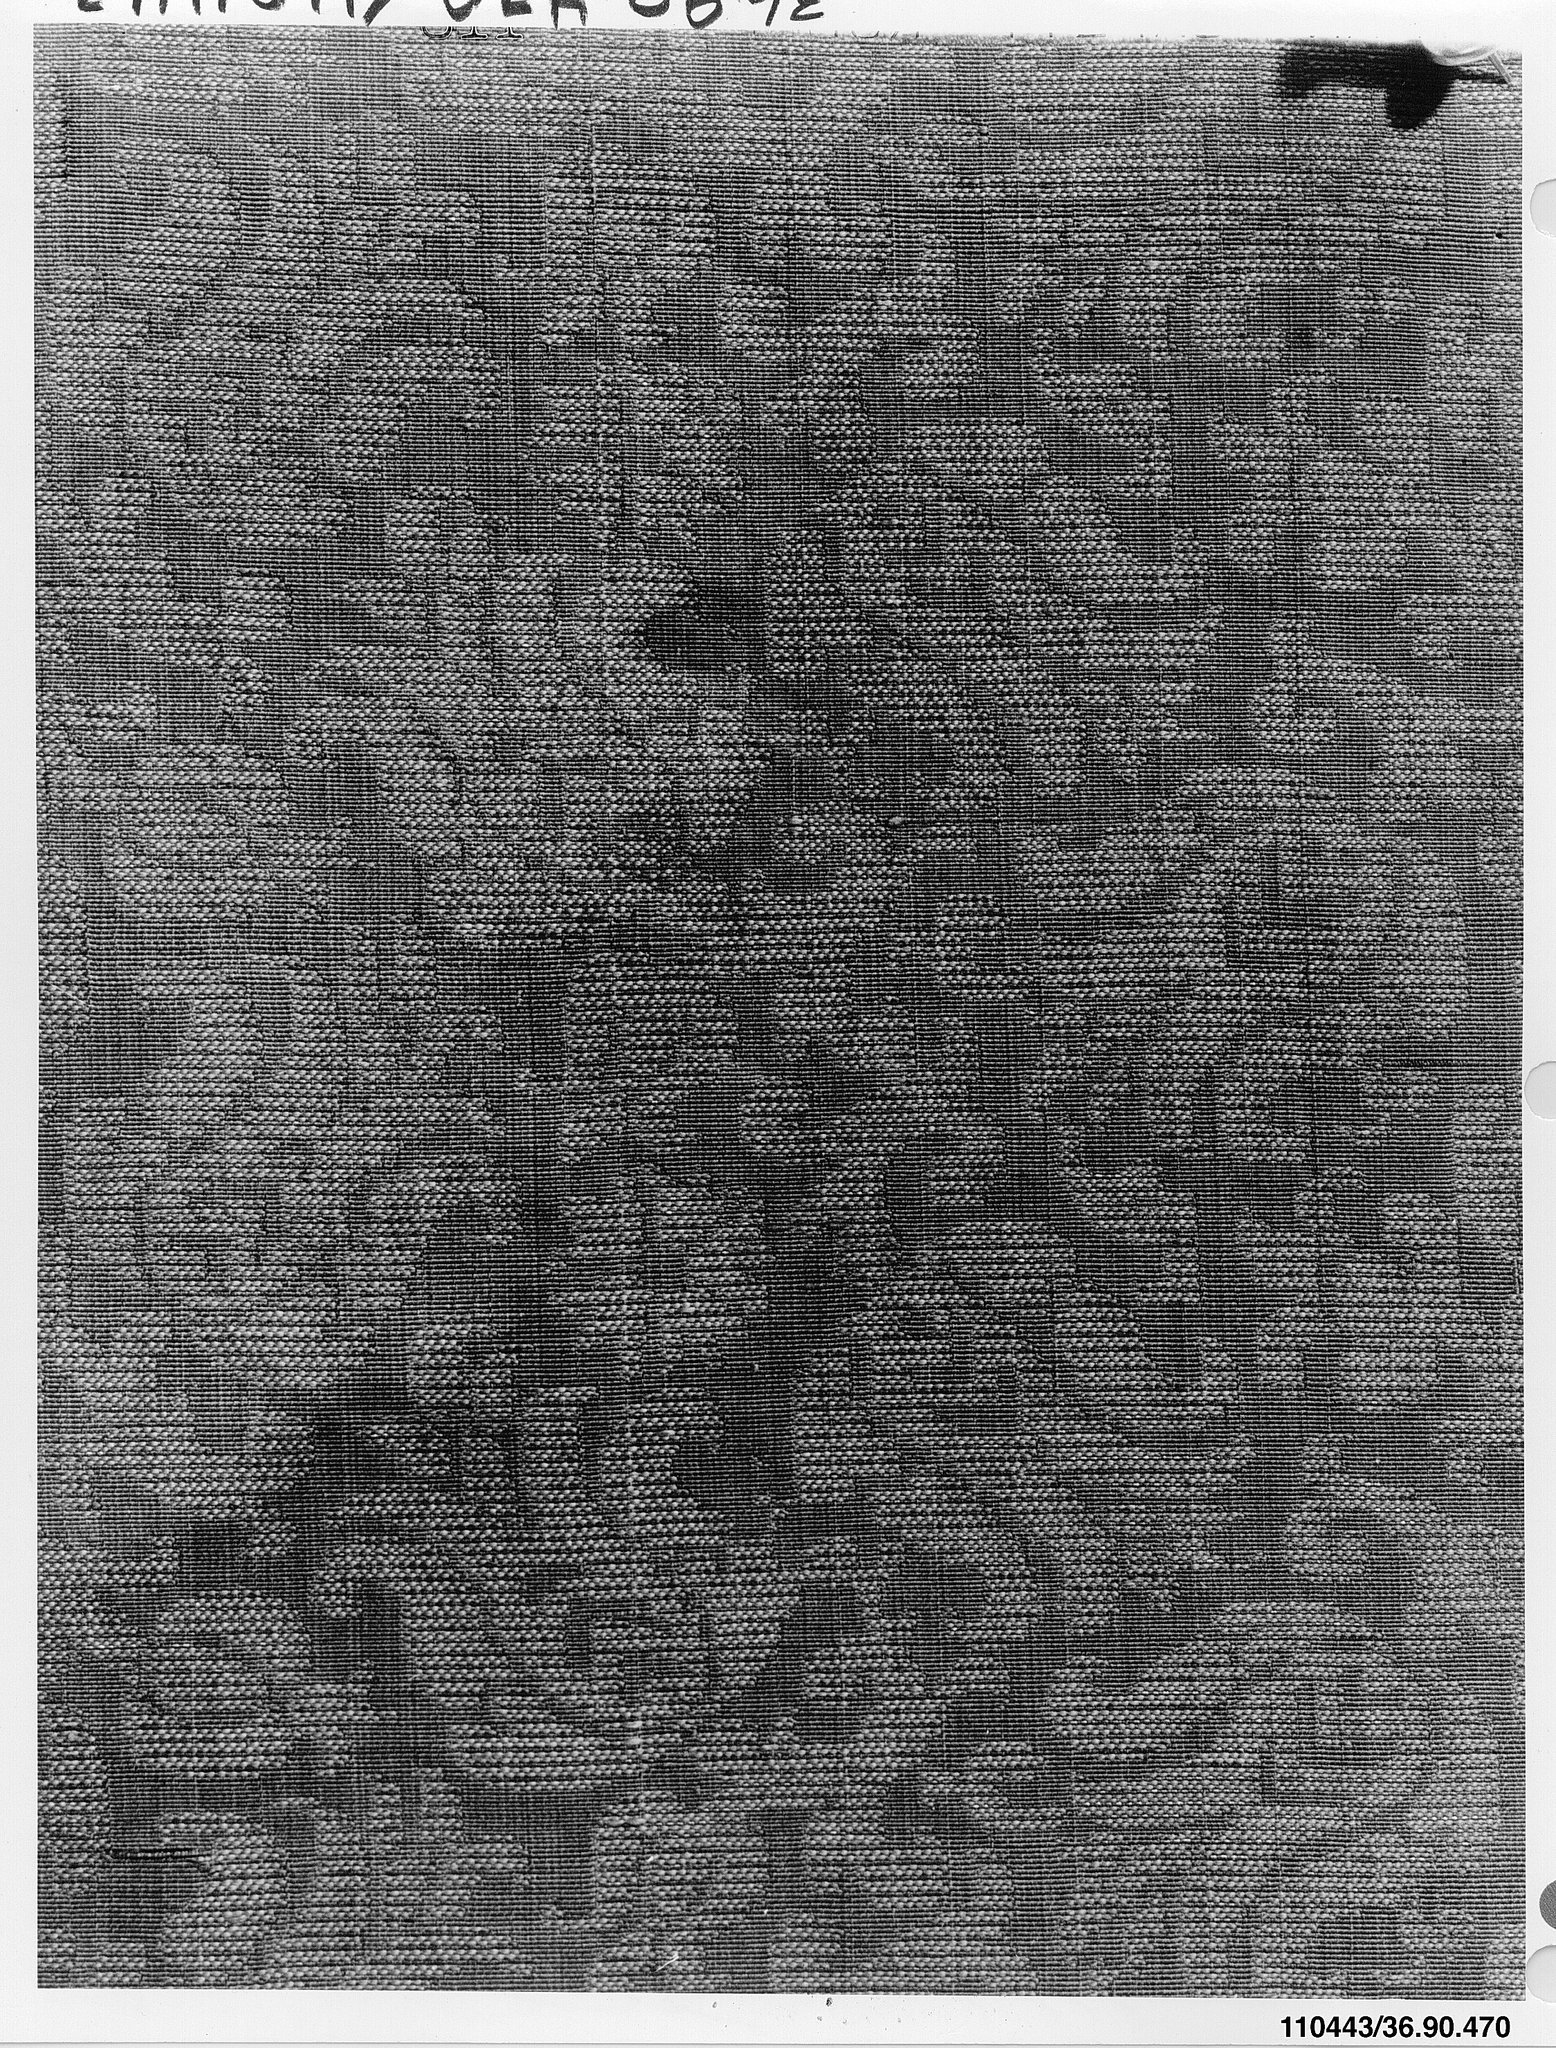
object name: piece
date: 1501-1700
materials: metal thread, silk